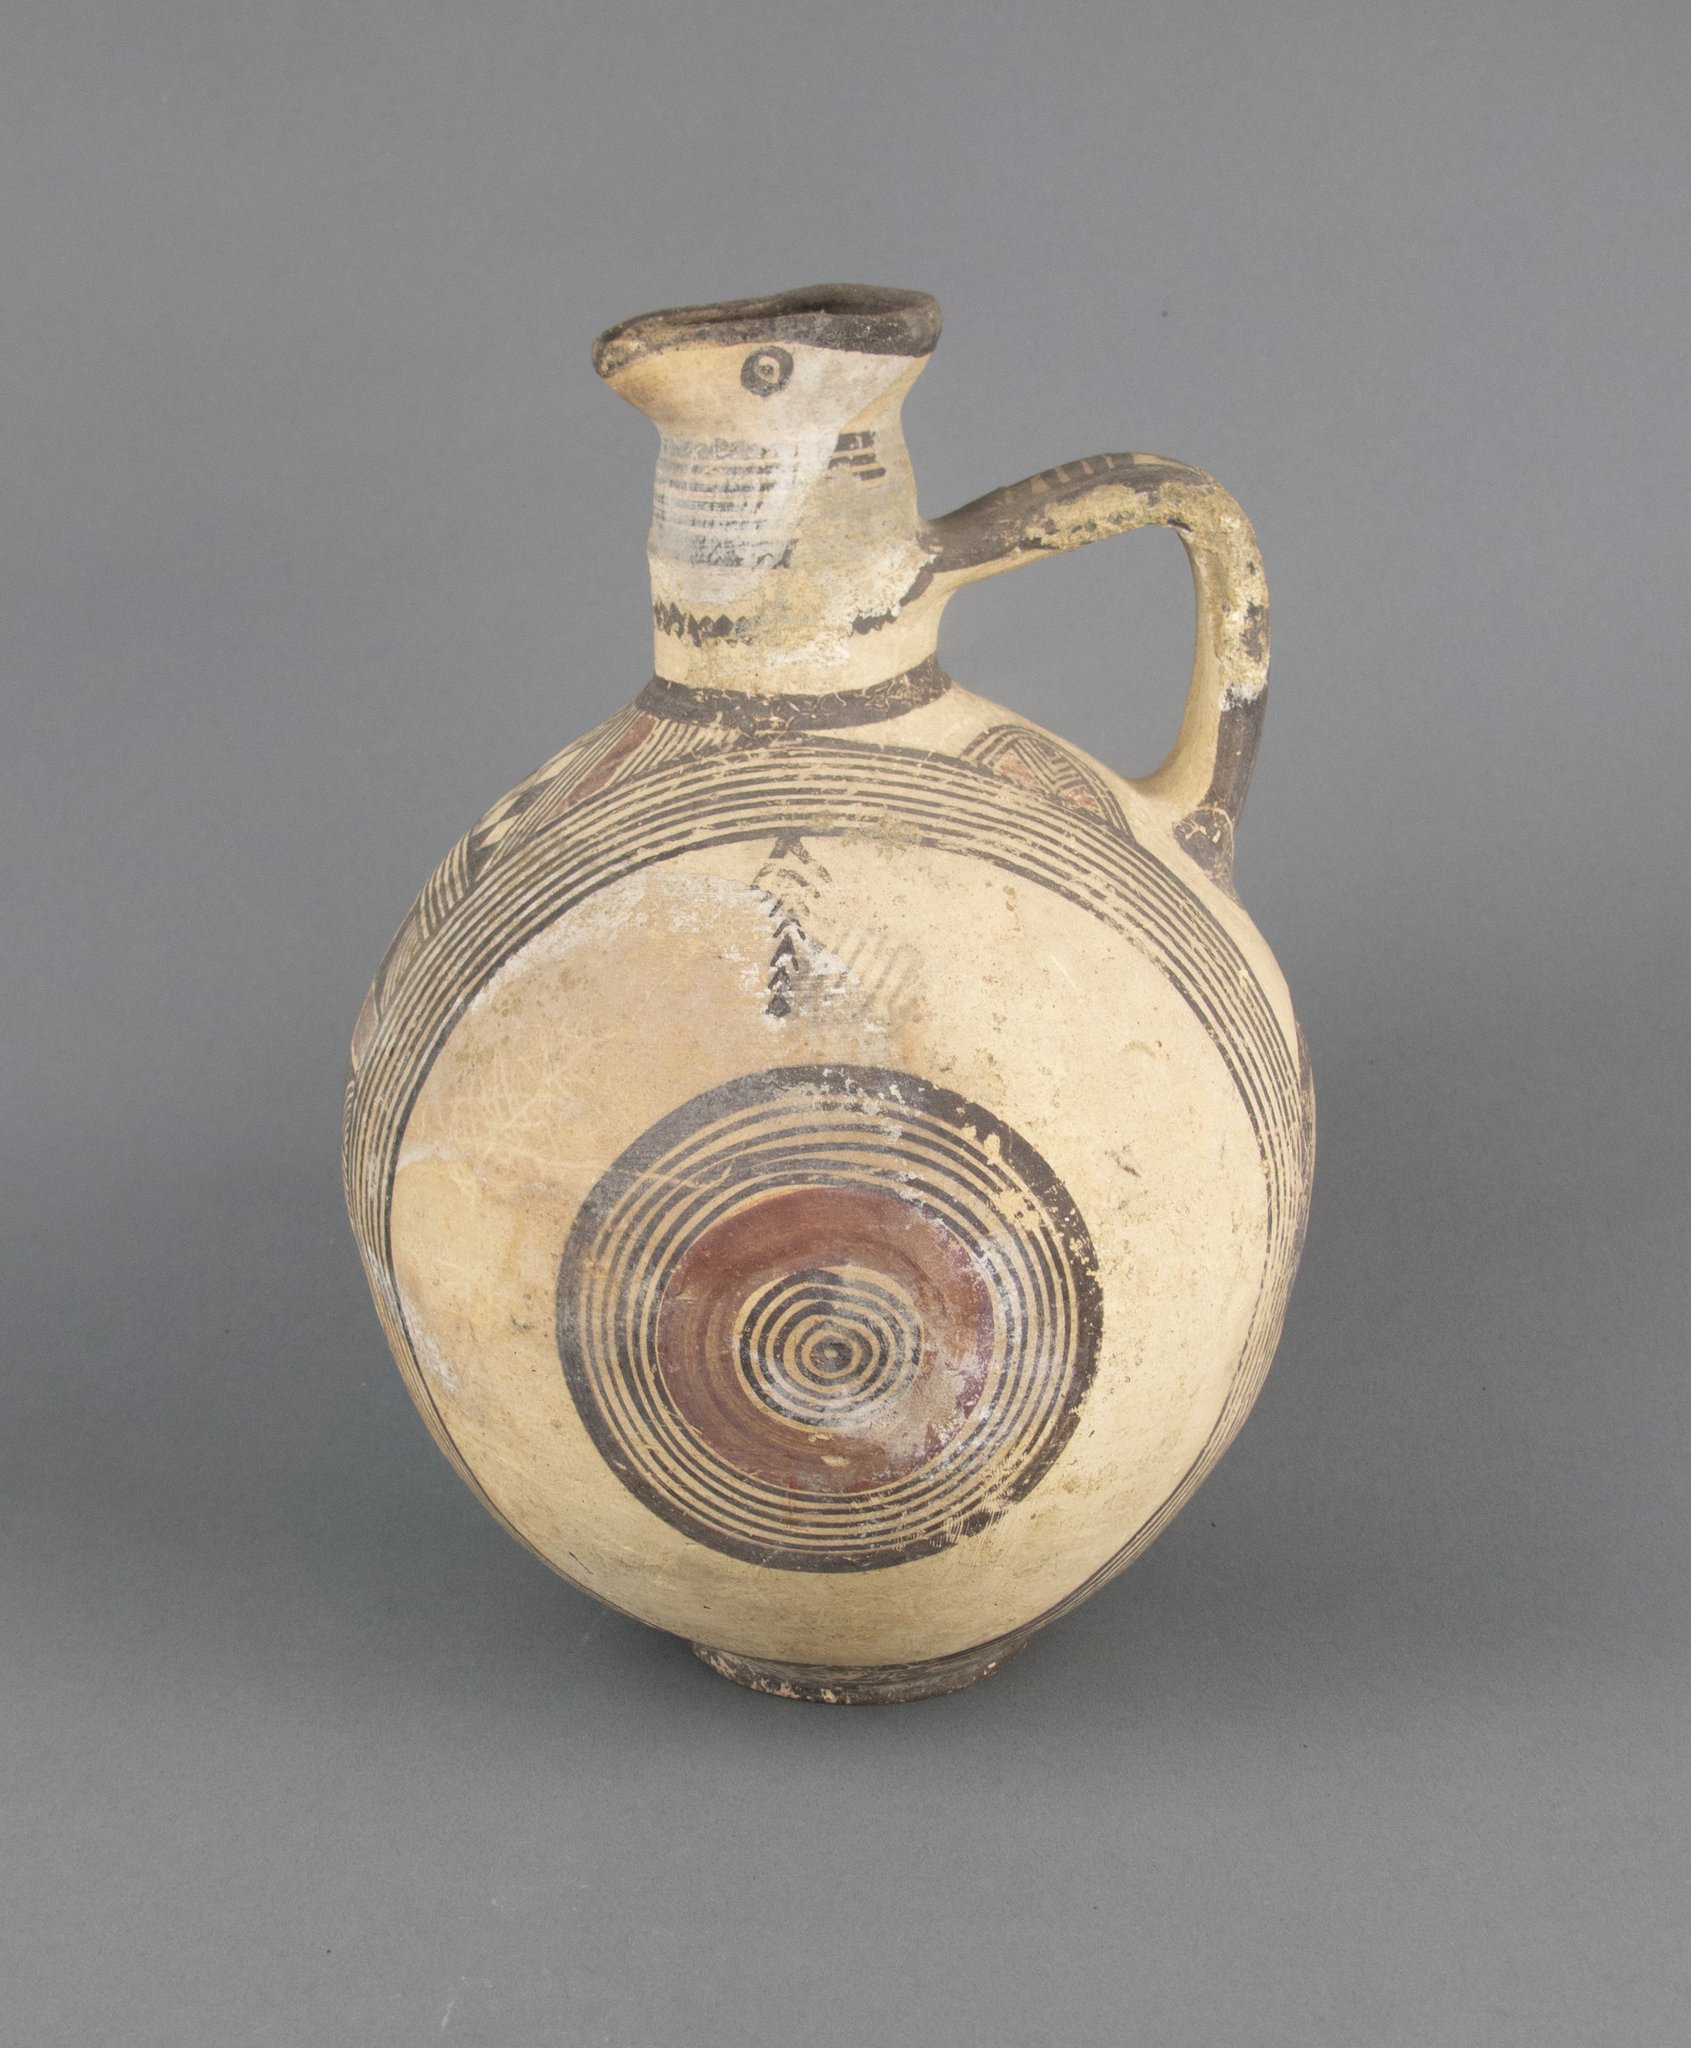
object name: jug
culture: cypriot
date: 750-600 BCE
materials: terracotta